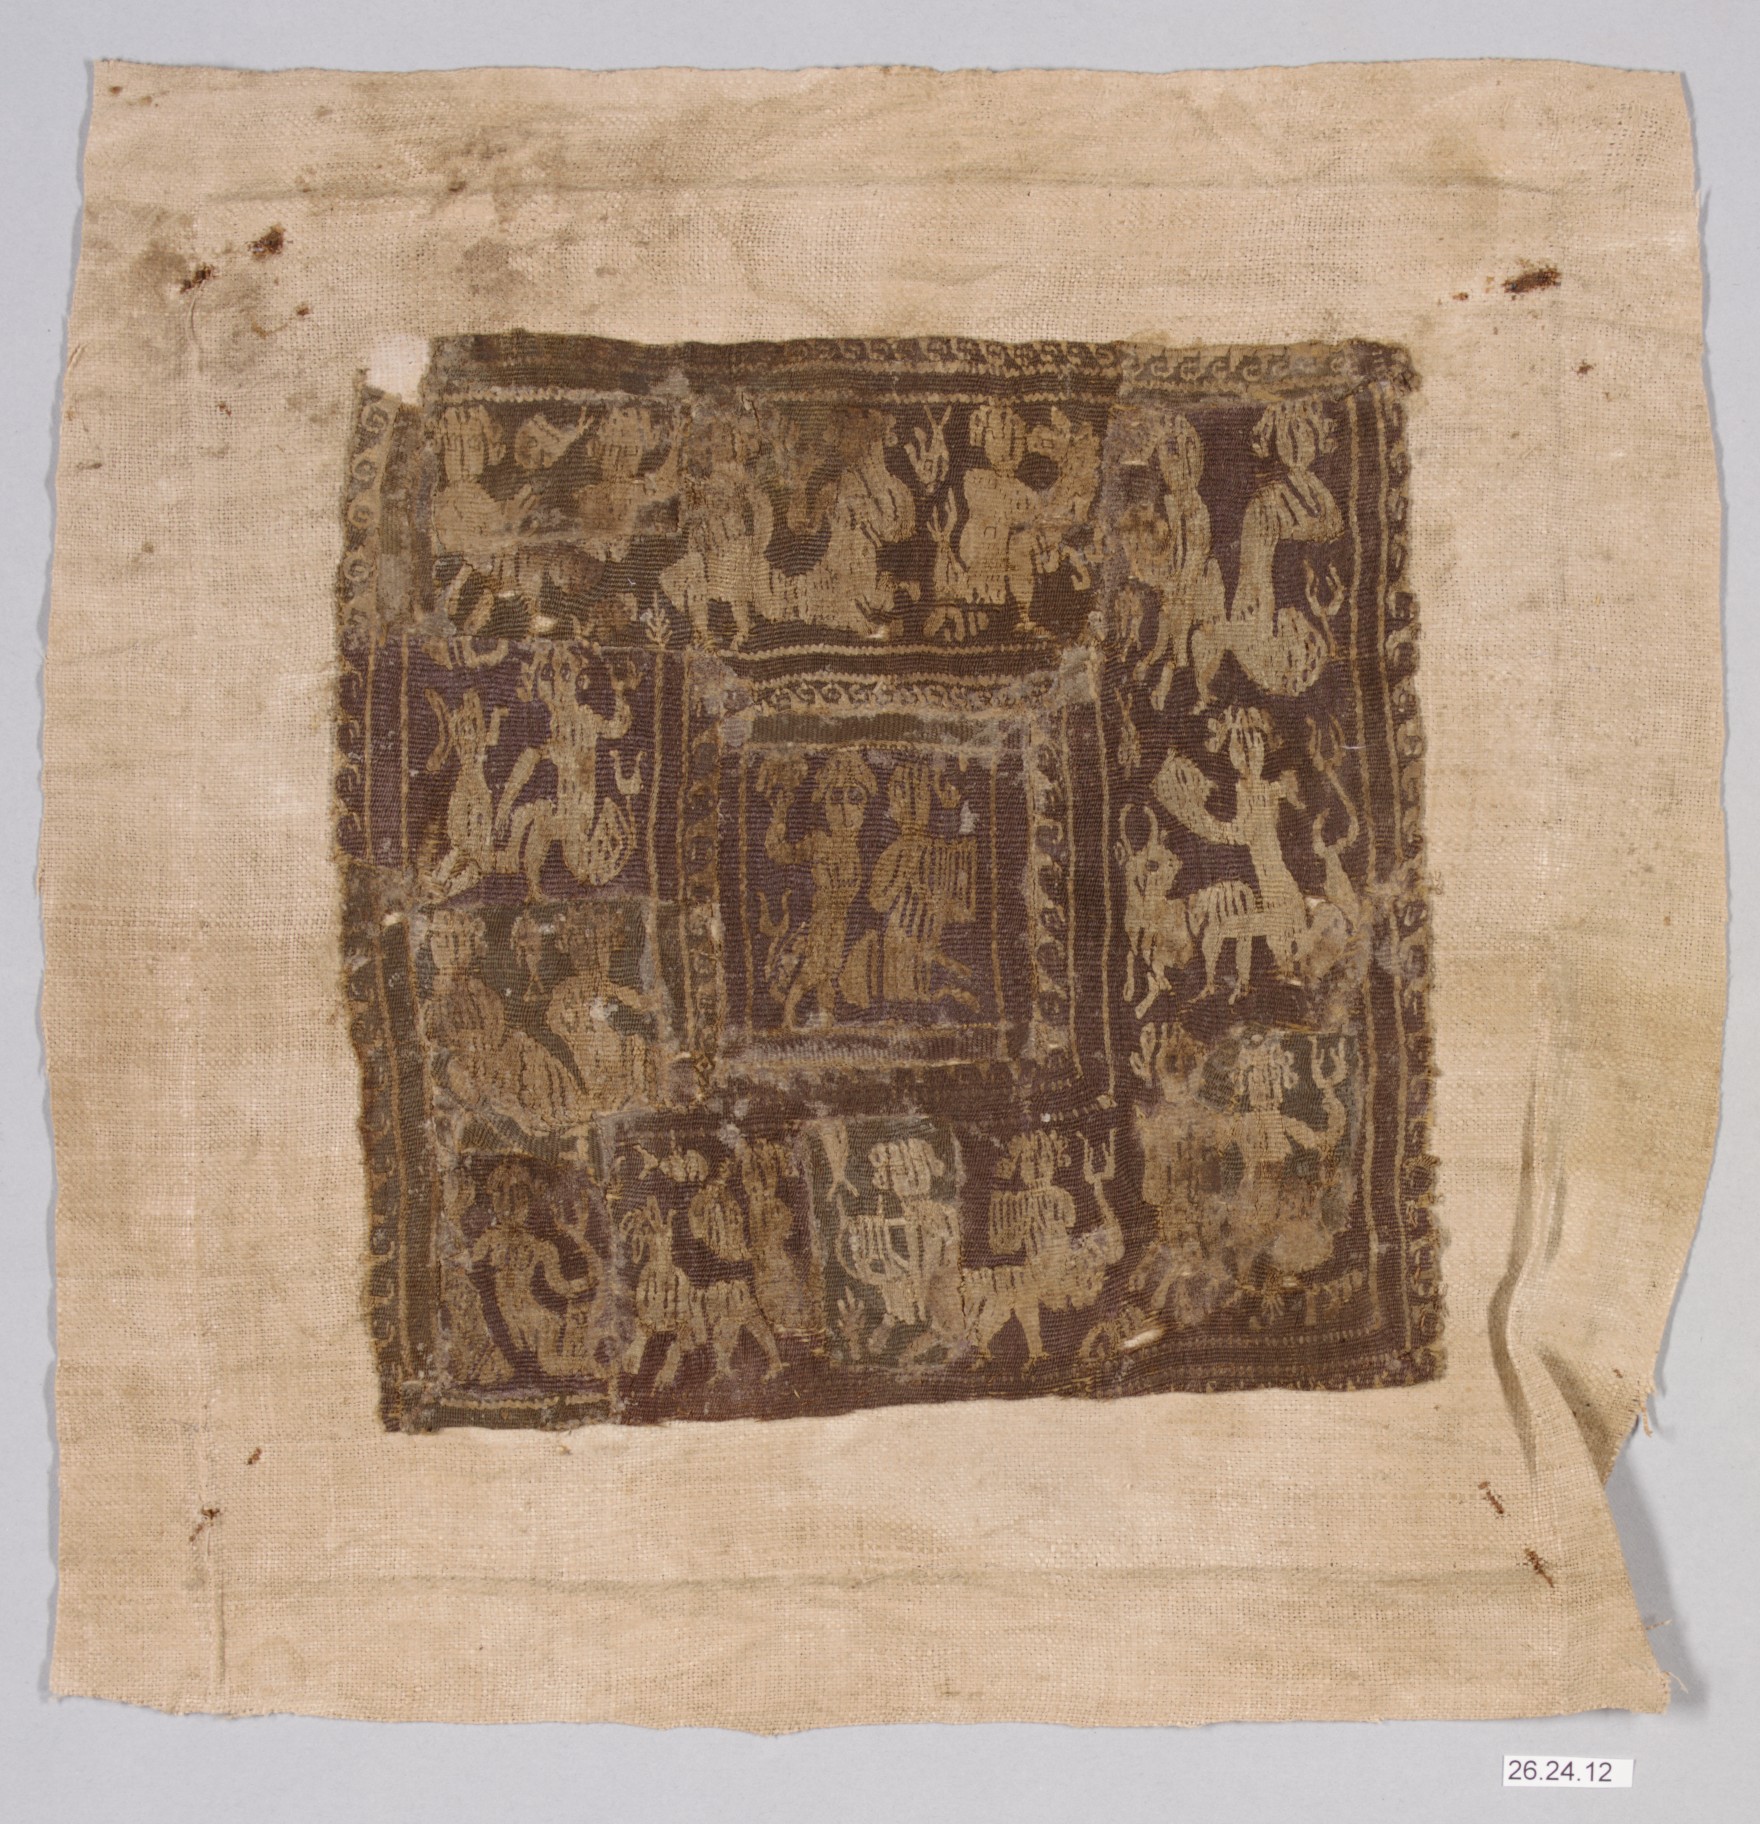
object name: panel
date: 301-400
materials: linen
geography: egypt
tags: animals,men